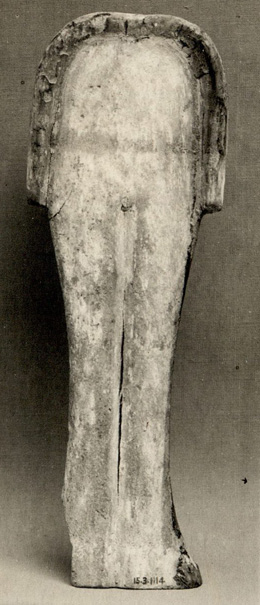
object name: bat amulet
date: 1981-1640 BCE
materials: wood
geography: egypt